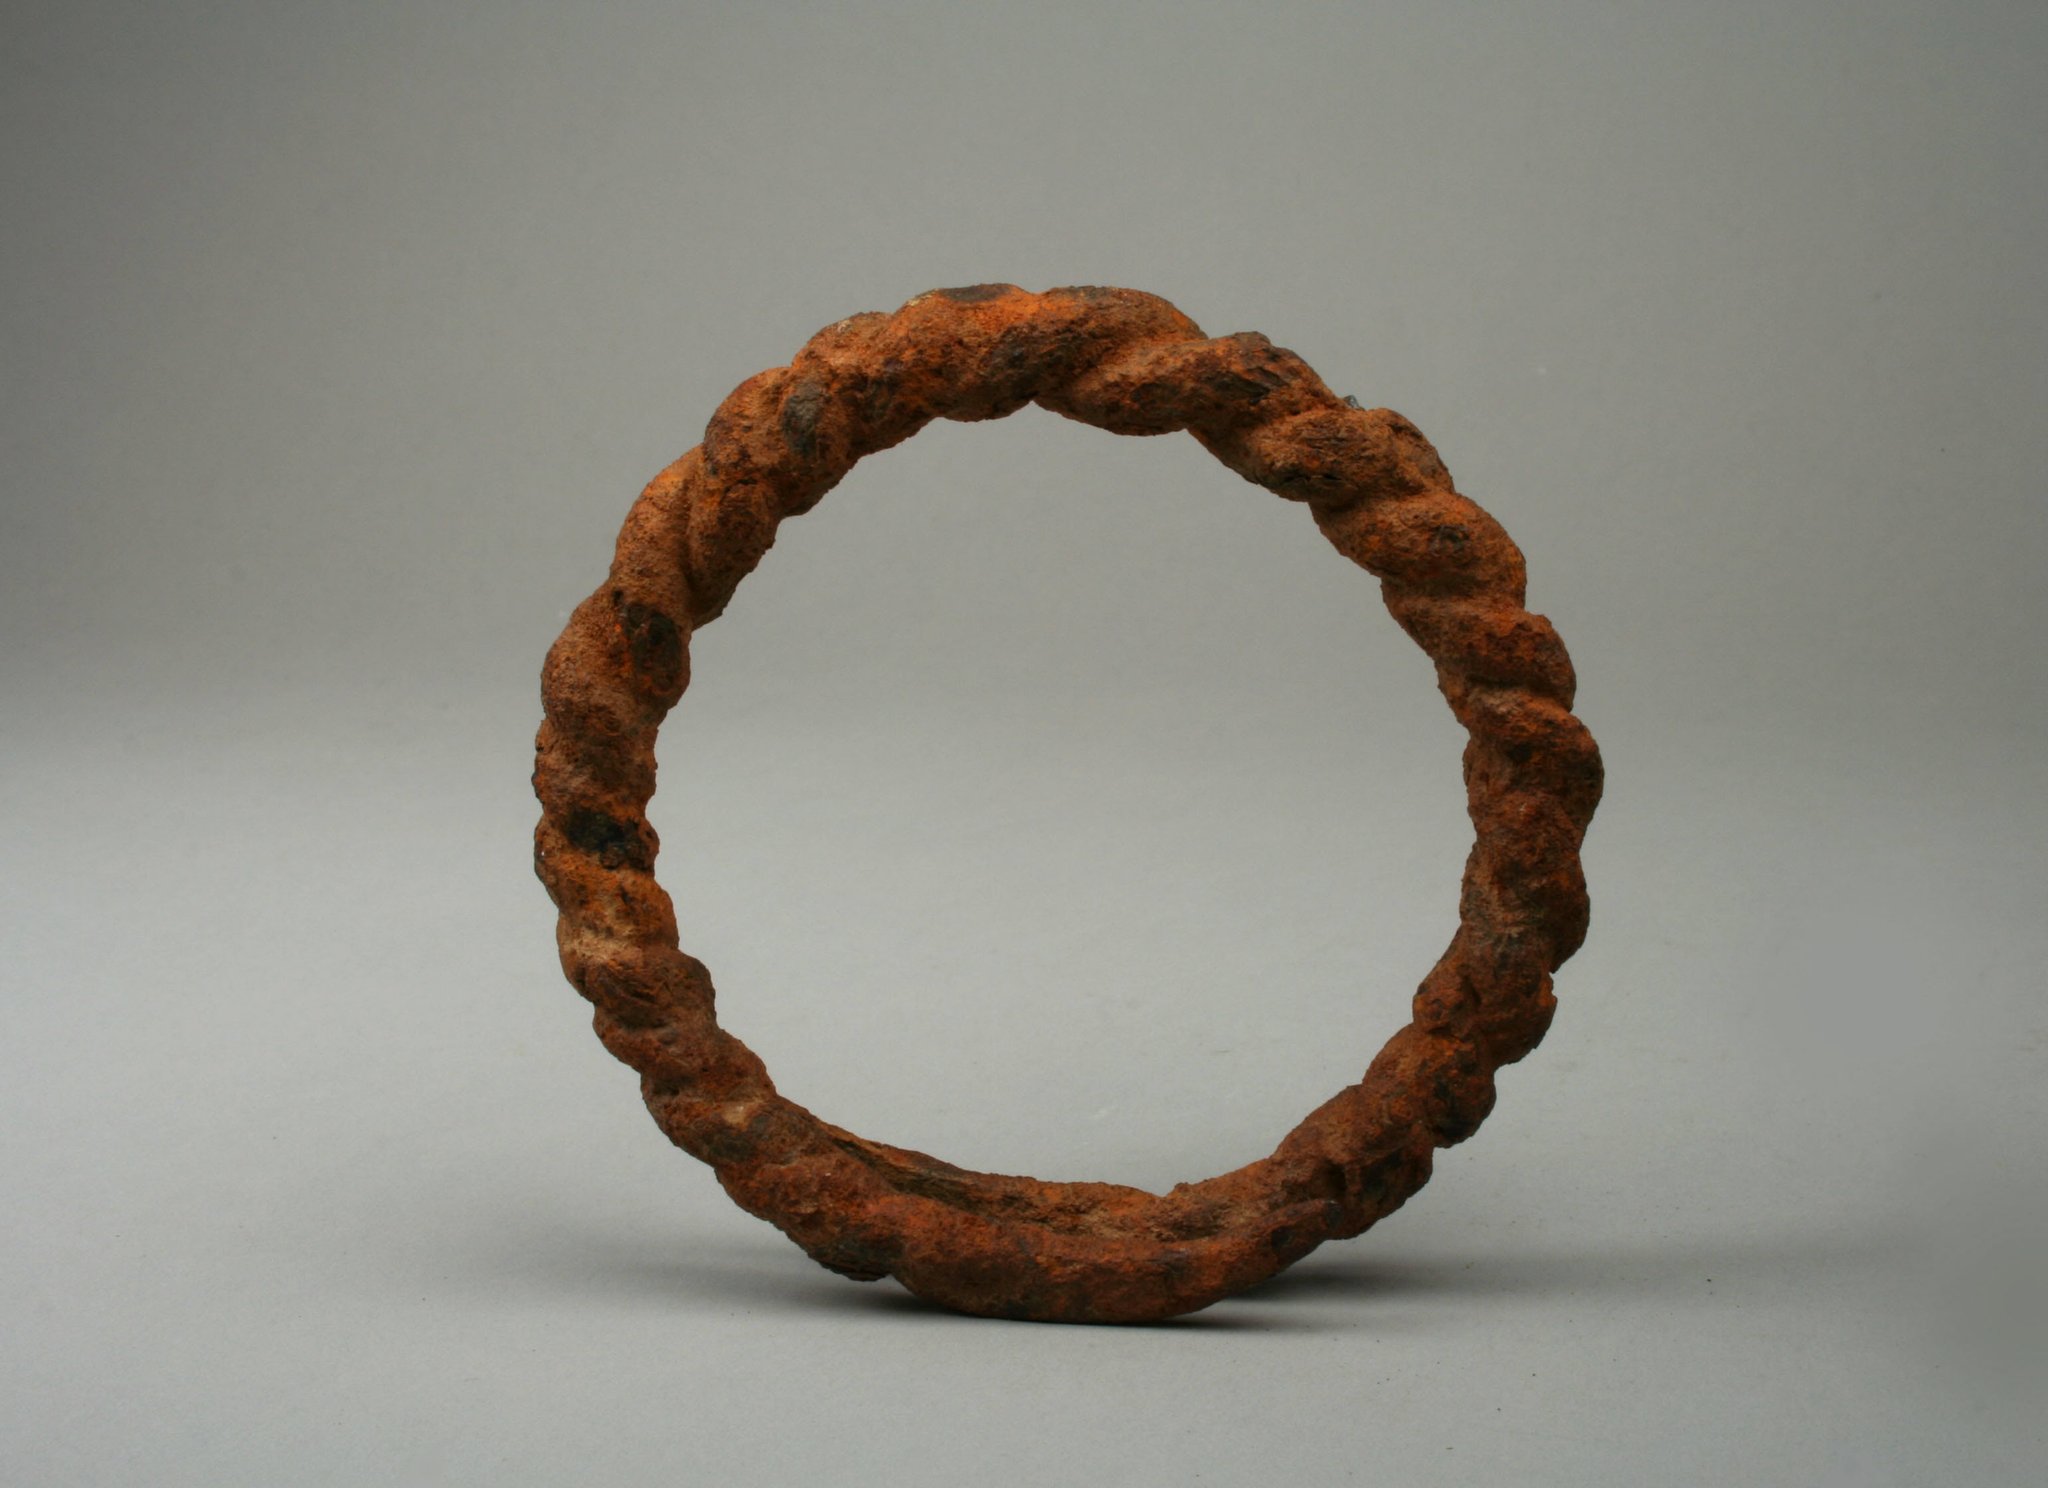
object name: bracelet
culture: bura peoples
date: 201-1100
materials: iron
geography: niger